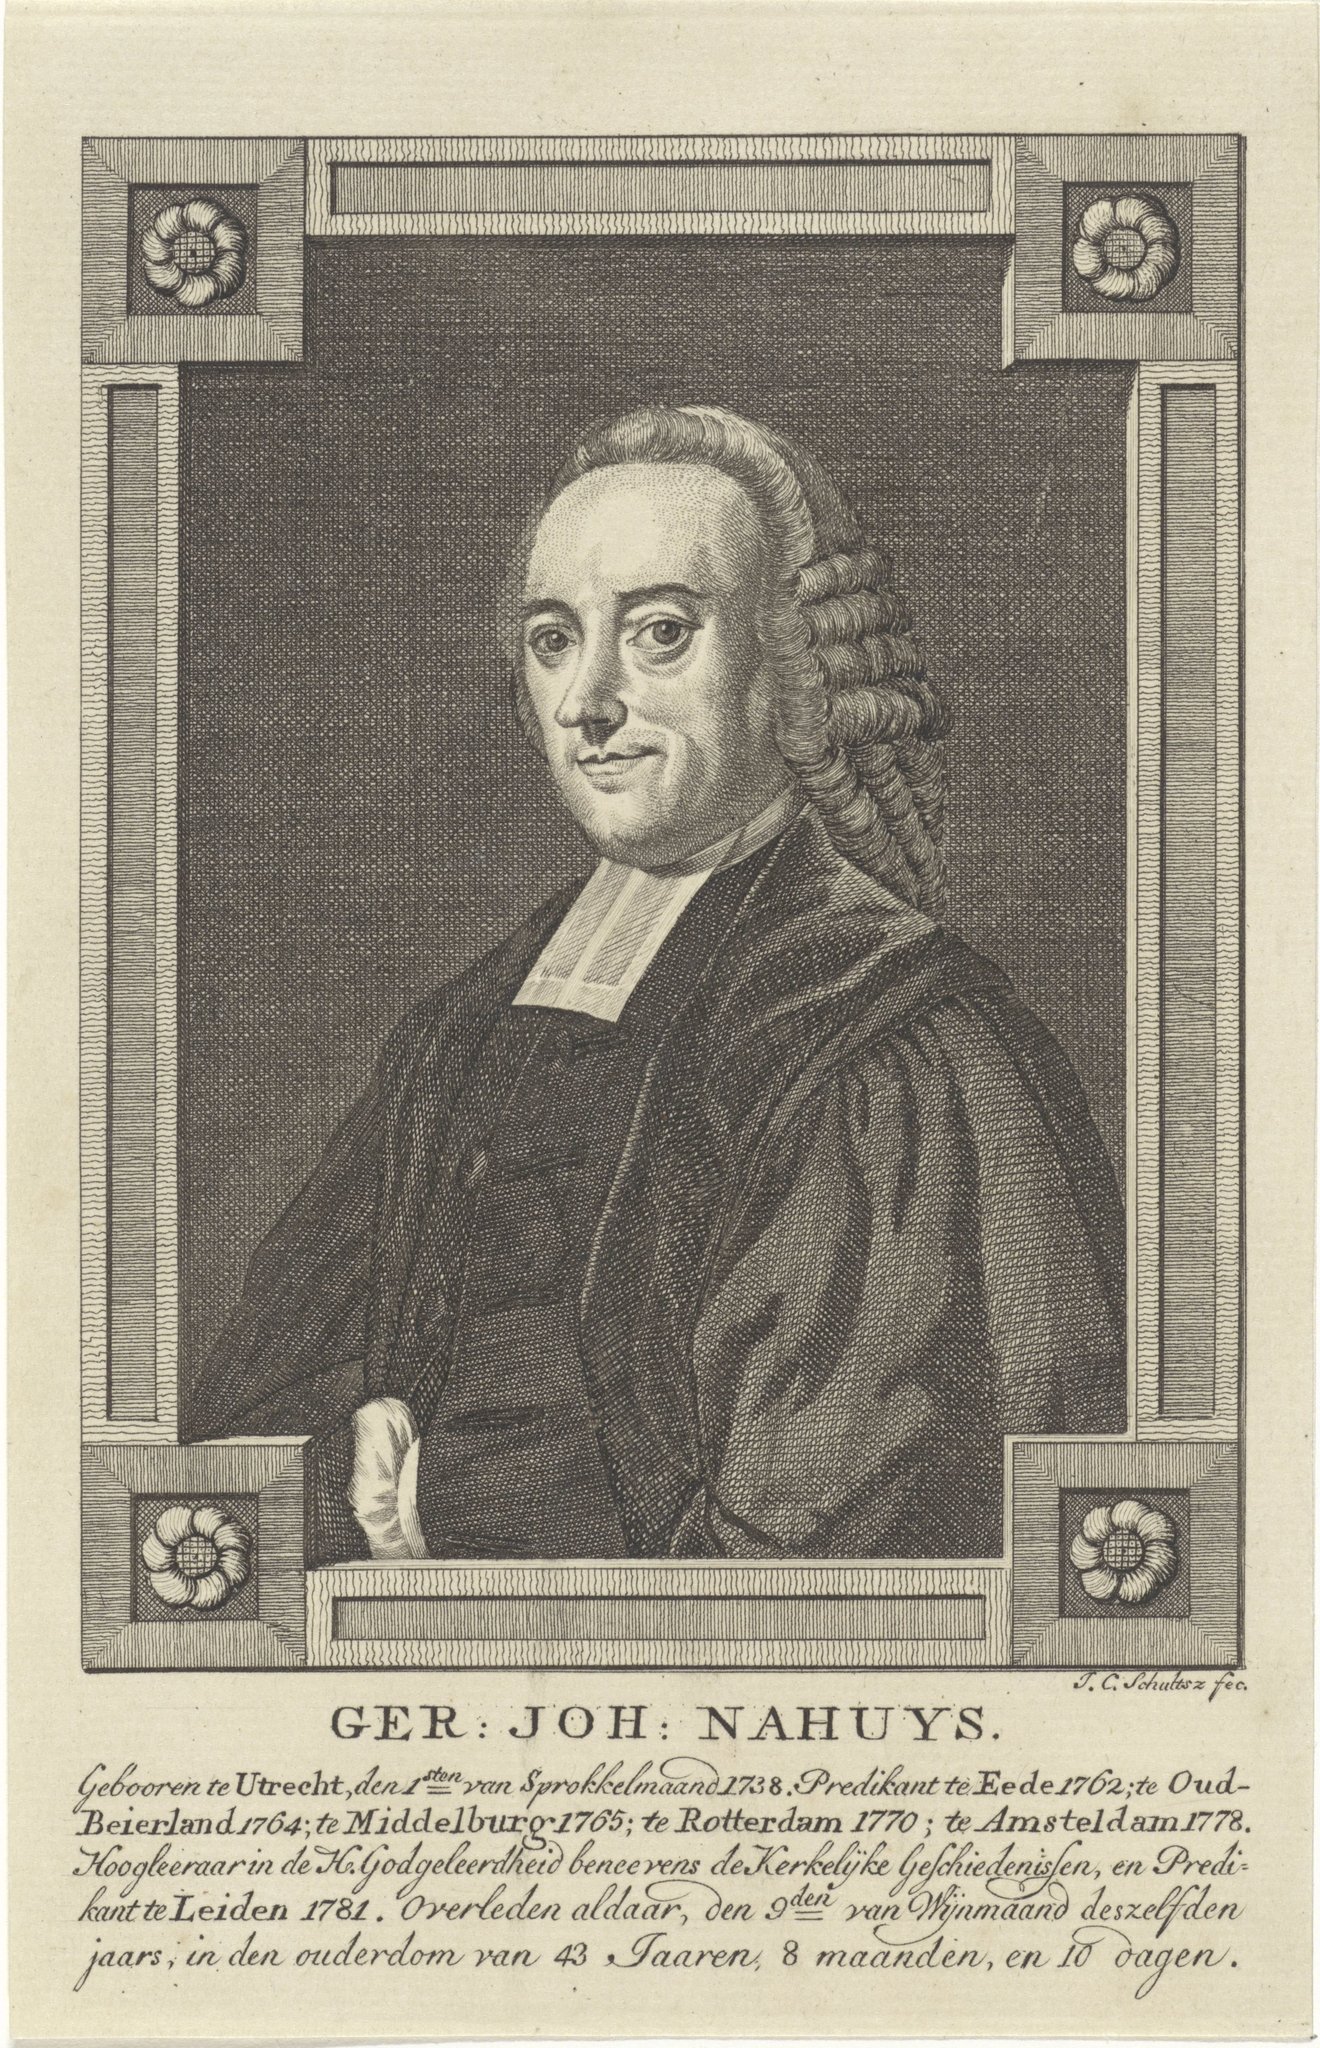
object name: print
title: Portret van predikant Gerard Johan Nahuys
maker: johan christoffel schultz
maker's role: print maker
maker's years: 1749-1812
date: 1781-1783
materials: paper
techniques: engraving, etching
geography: amsterdam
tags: leiden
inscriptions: collector's mark: Lugt 2228